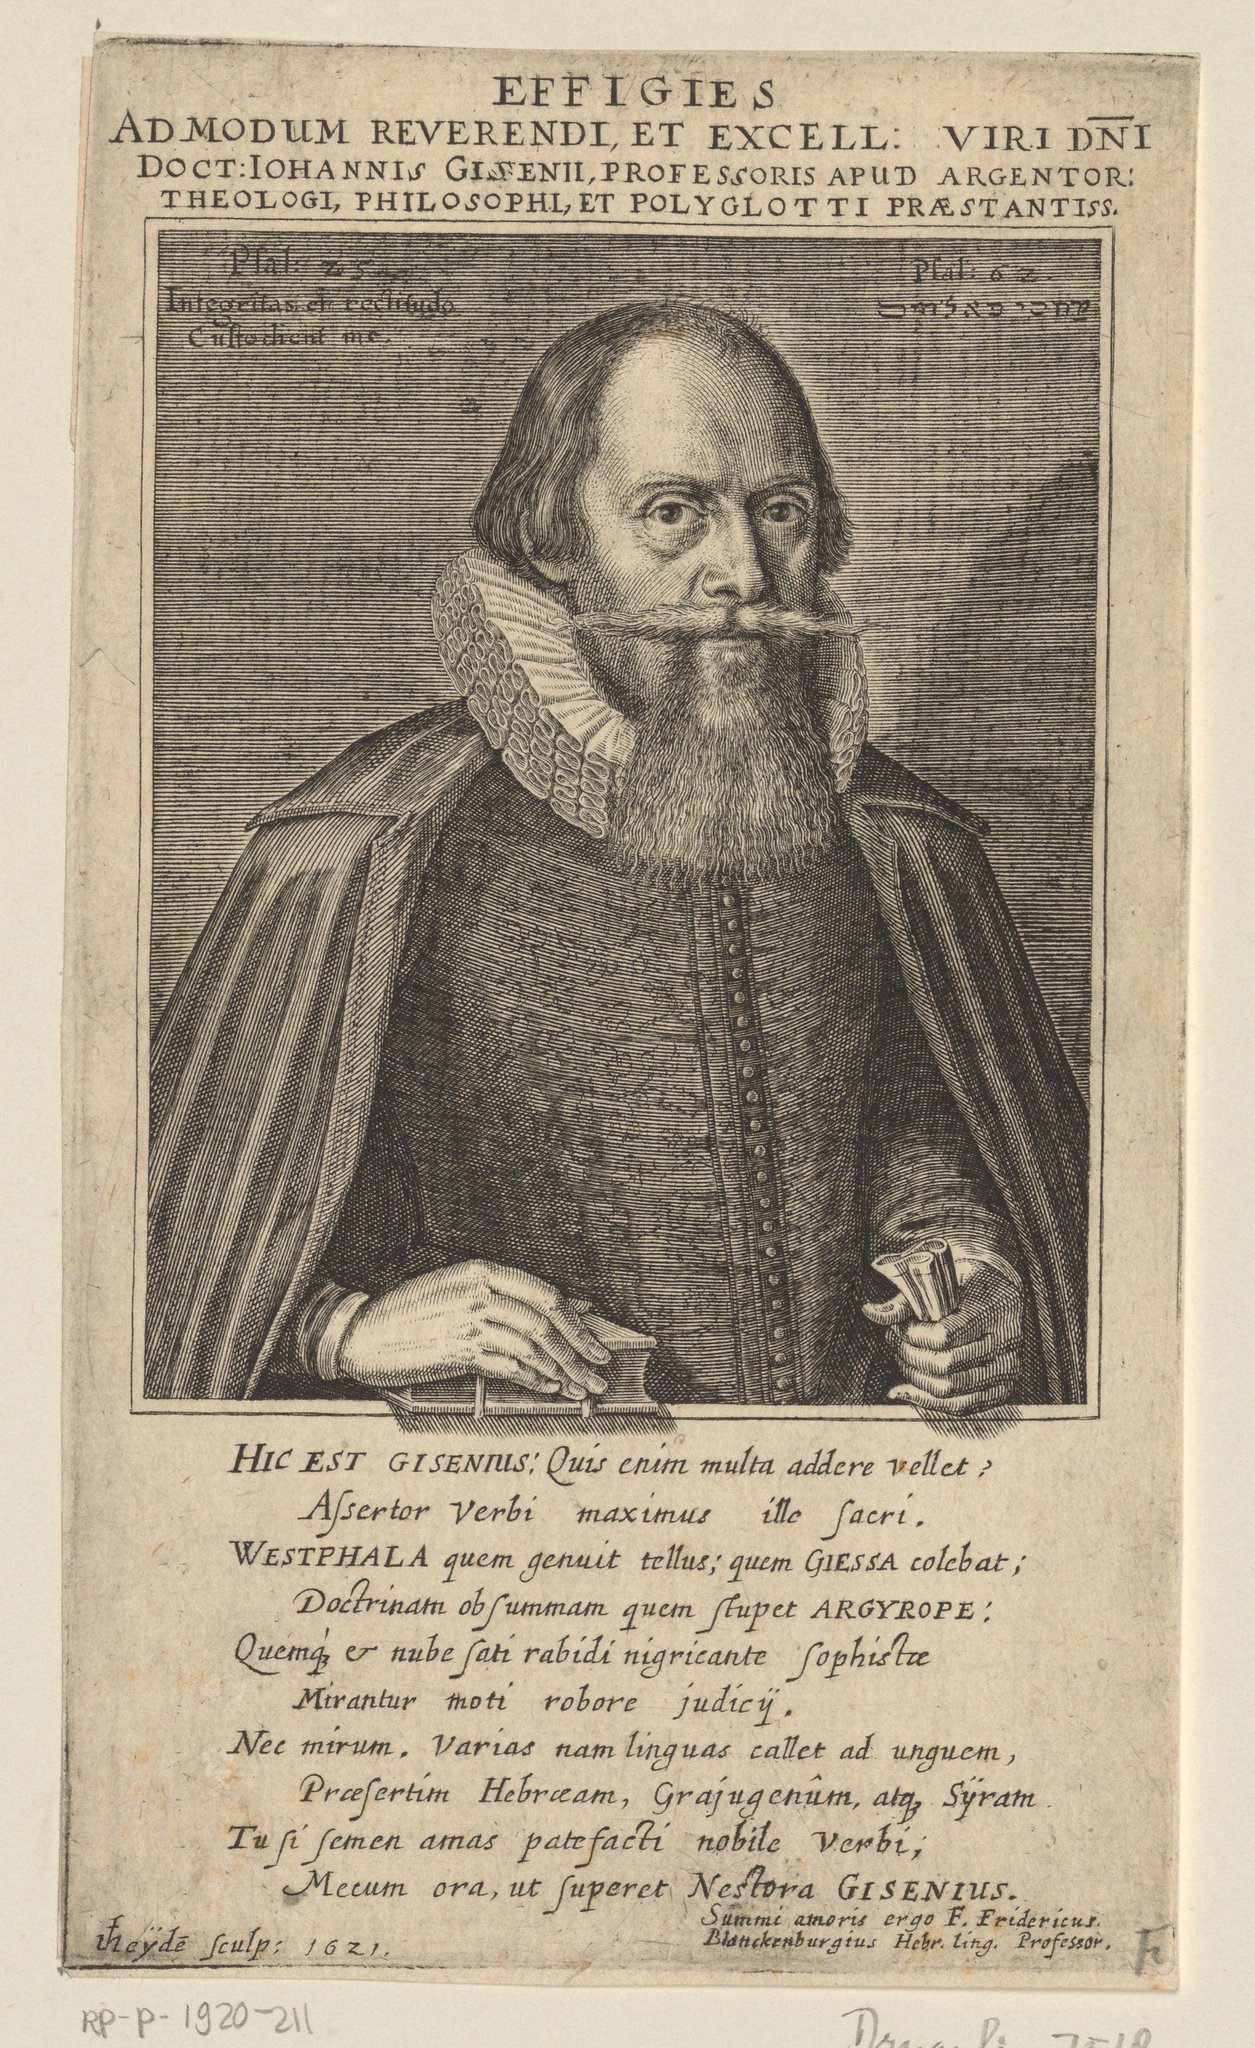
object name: print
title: Portret van Johannes Gisenius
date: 1621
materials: paper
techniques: engraving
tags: theologian, gloves, mittens, etc., historical persons, book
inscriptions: collector's mark: Lugt 2228